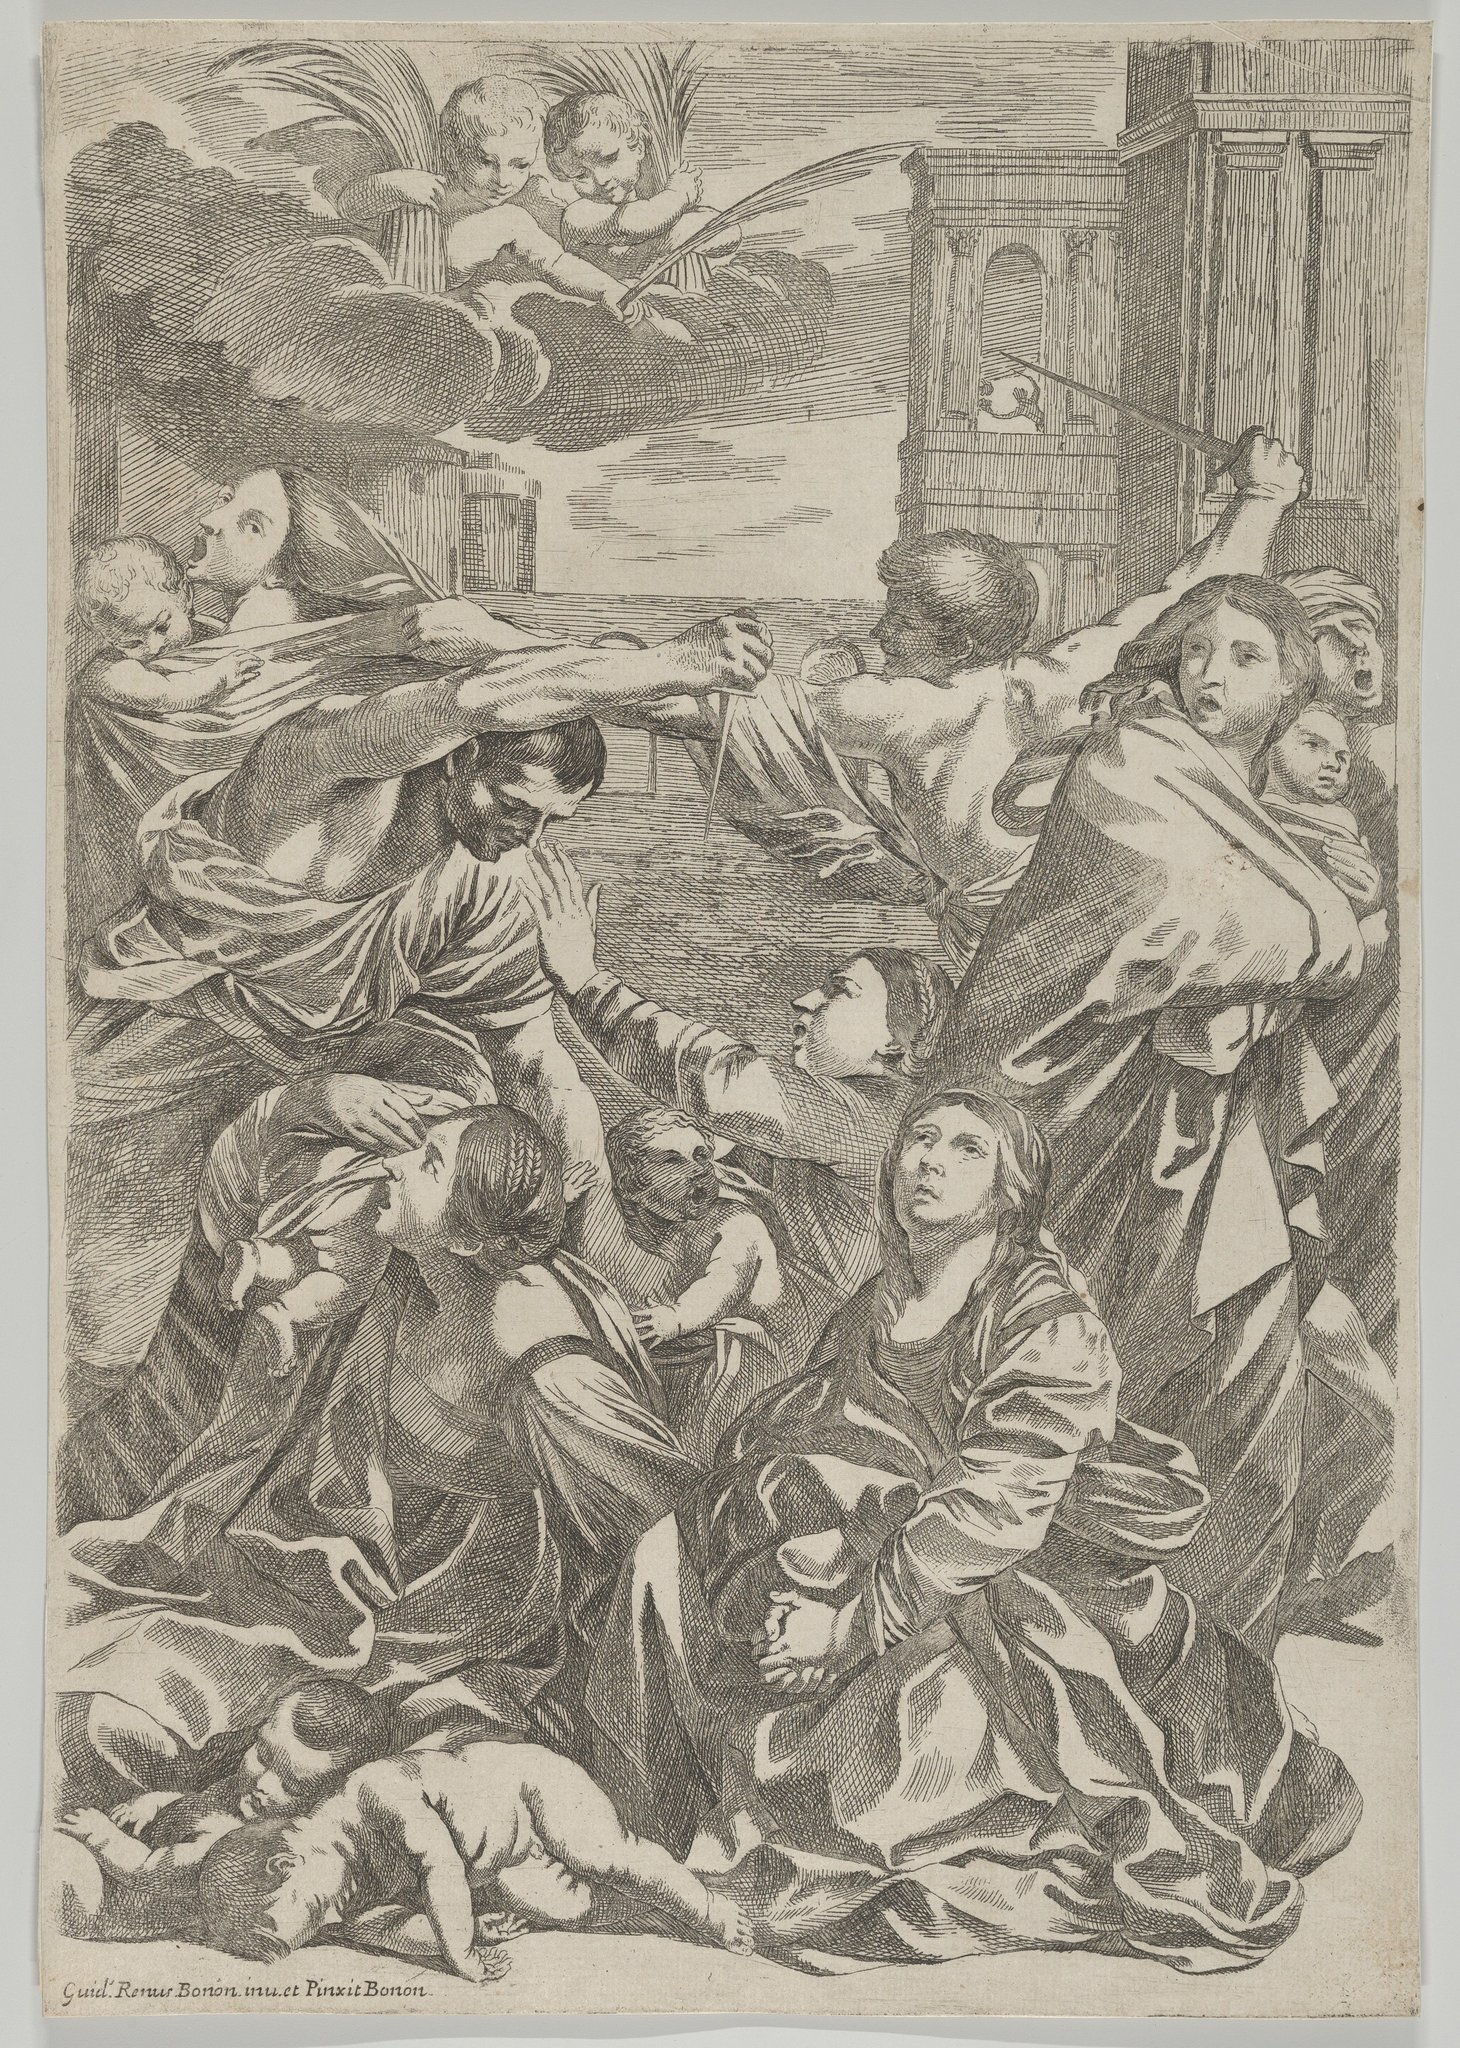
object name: print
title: Massacre of the Innocents; group of women and children being attacked, two angels at upper left, after Reni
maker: Anonymous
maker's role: artist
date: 1640-1700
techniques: etching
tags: massacres,suffering,children,men,women,angels